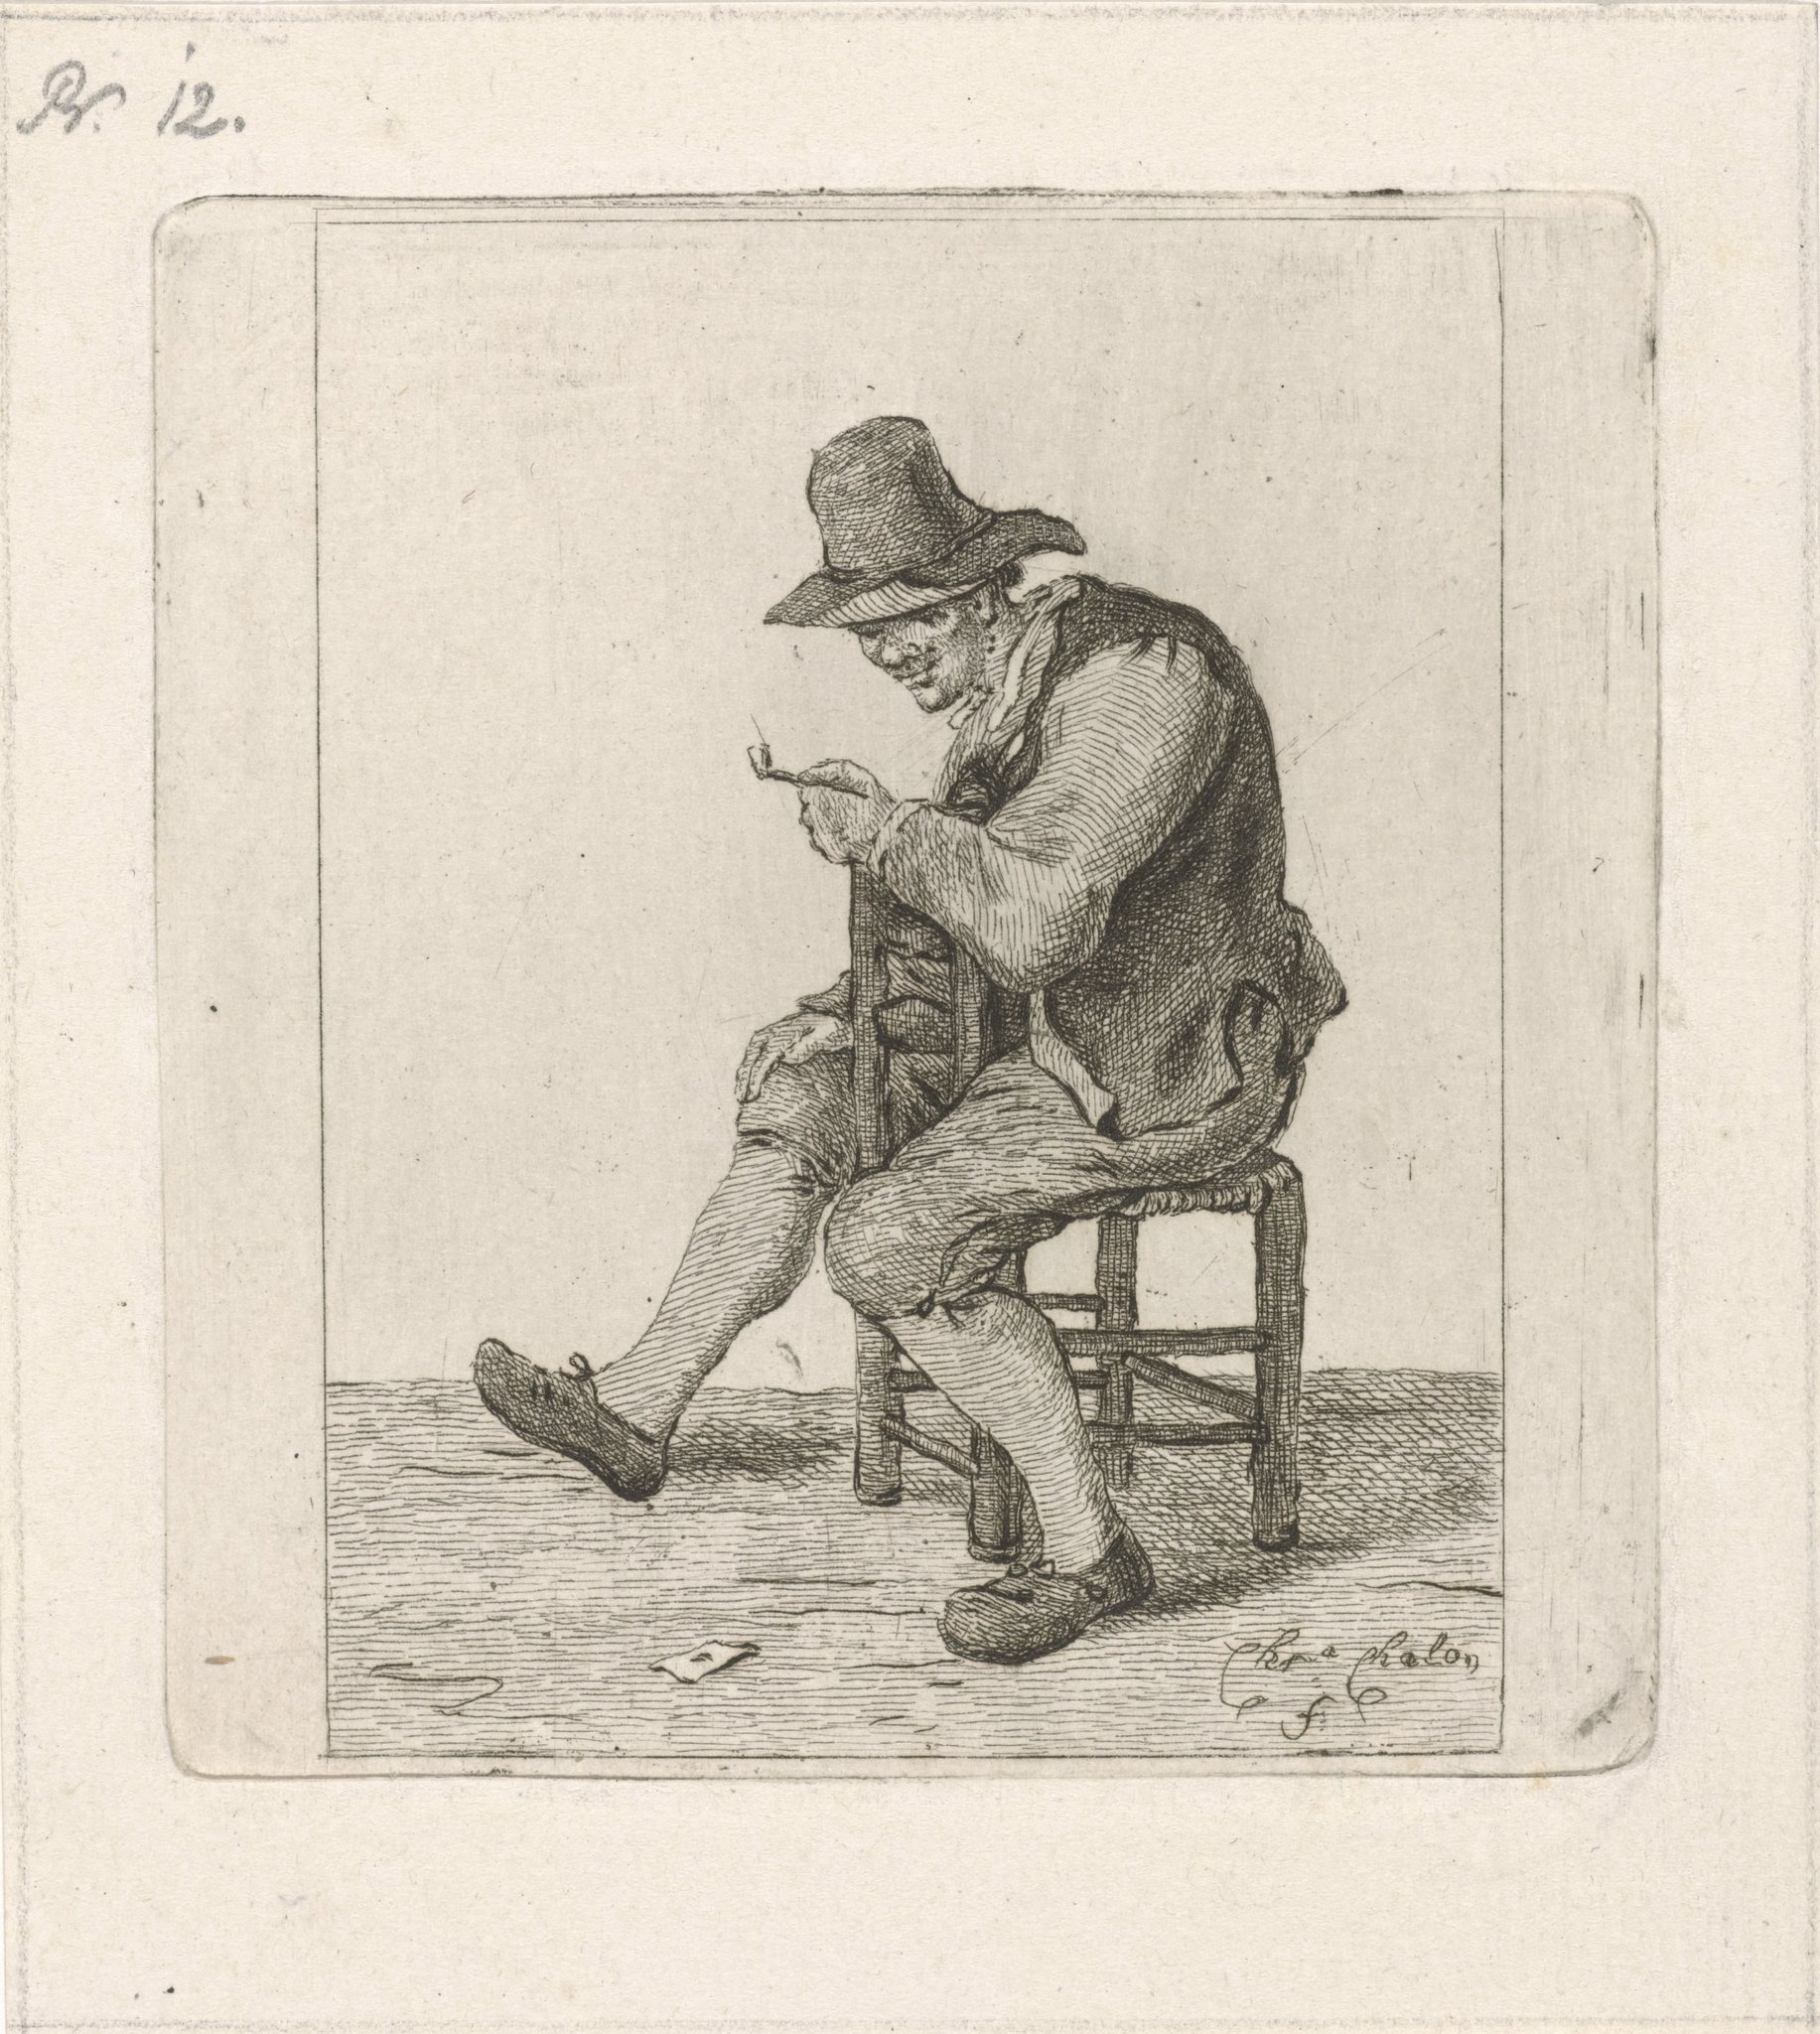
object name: print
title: Rokende boer met pijp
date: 1779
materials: paper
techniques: etching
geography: leiden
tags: pipe ~ tobacco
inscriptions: collector's mark: Lugt 240